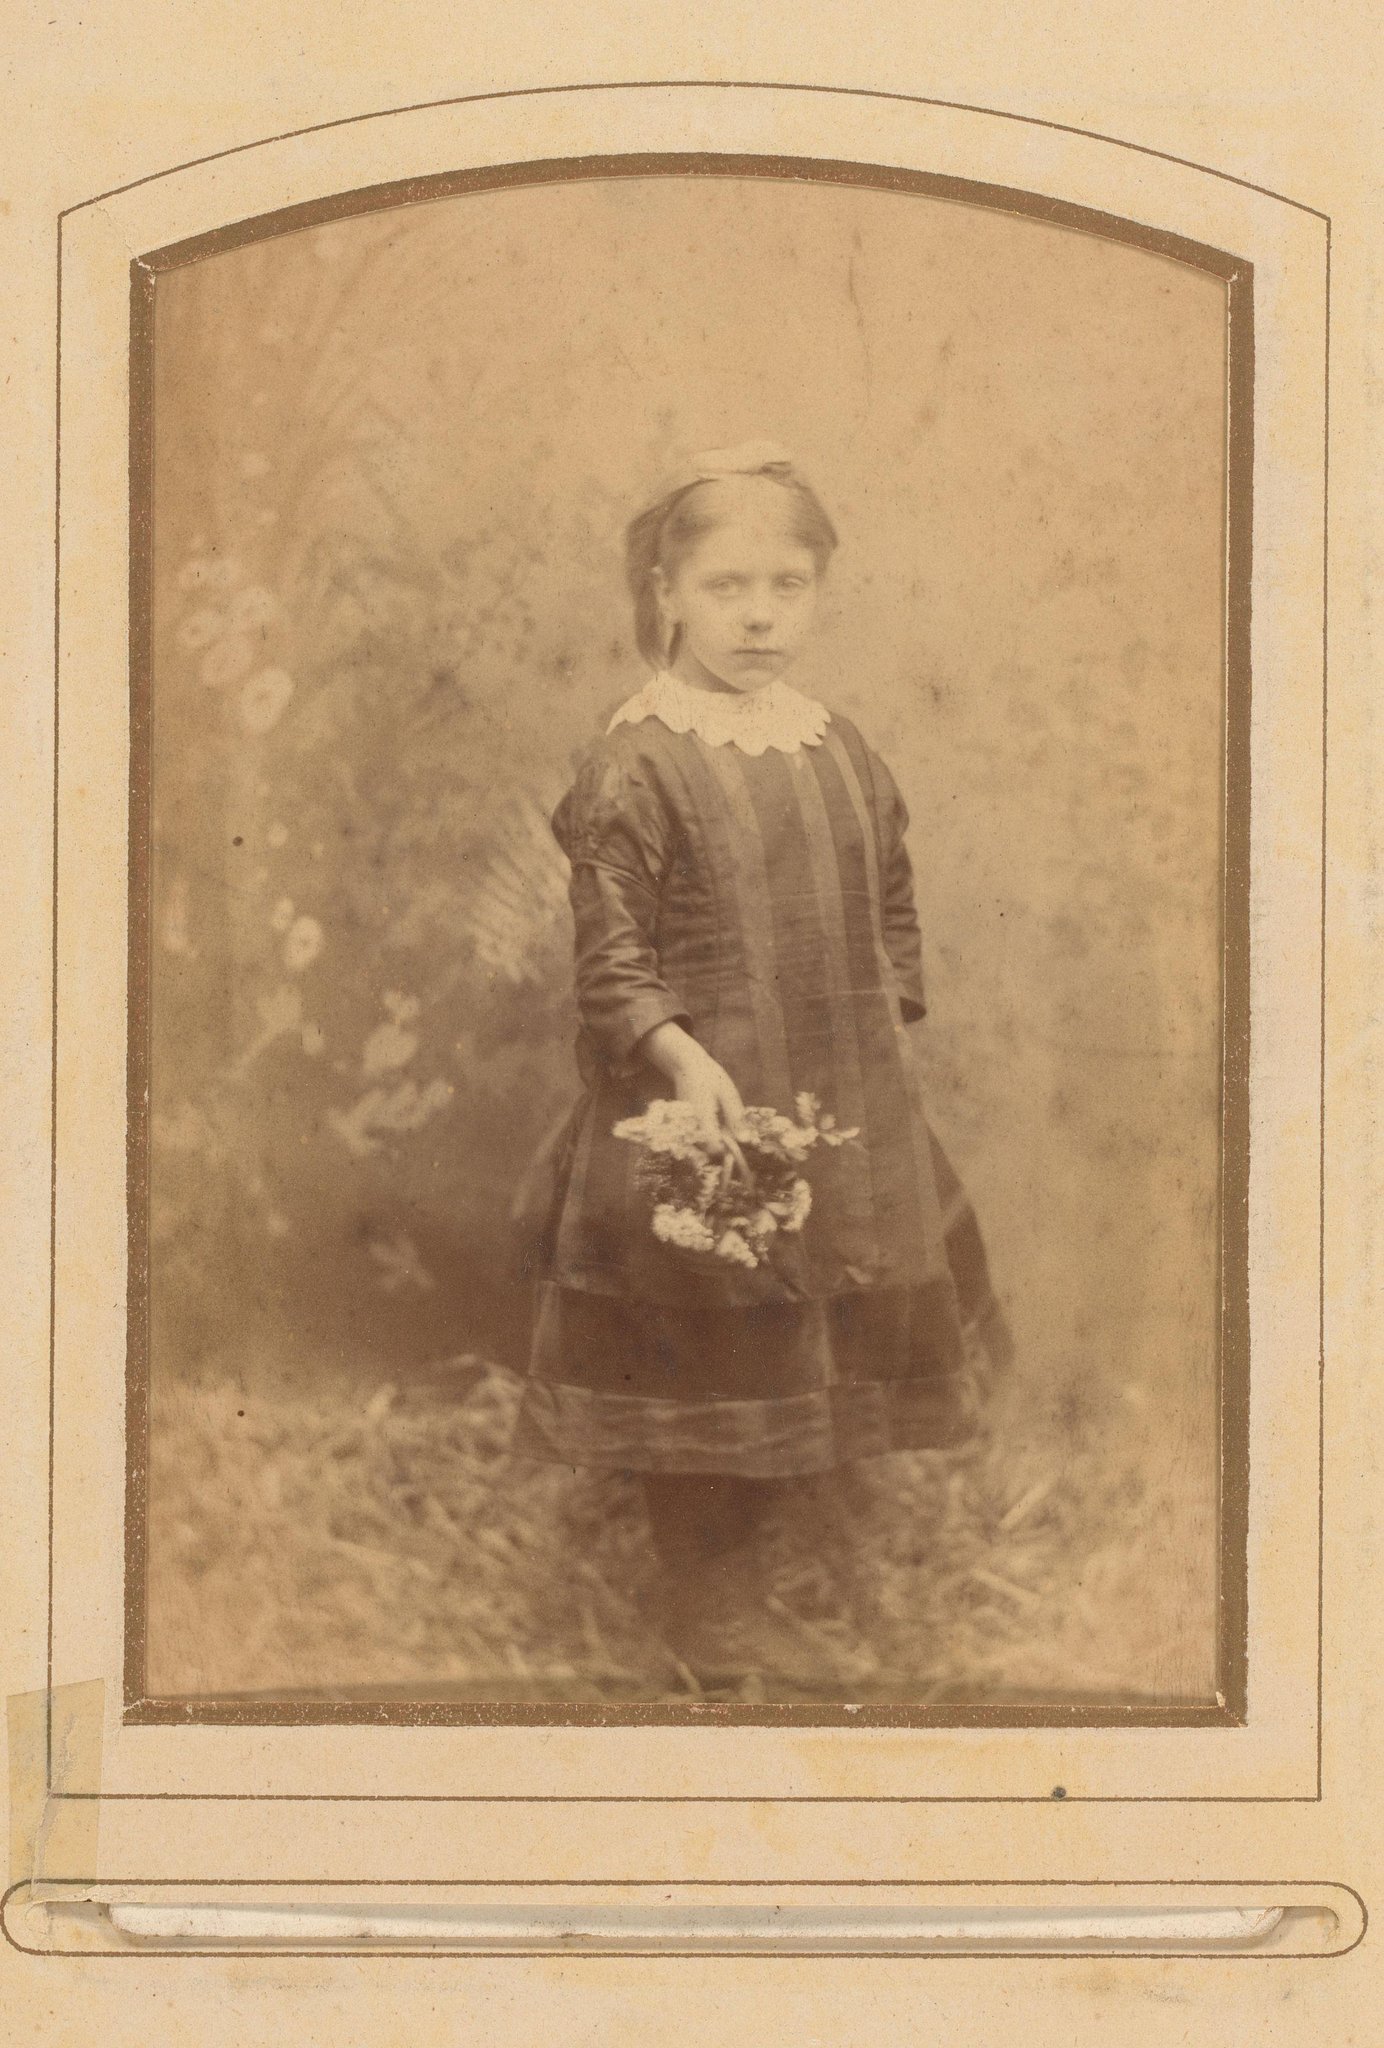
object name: album leaf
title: Portret van een staand meisje met bloemen in de hand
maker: Anonymous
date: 1860-1890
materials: cardboard, photographic support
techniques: albumen print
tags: flowers, historical persons - bb - woman, girl (child between toddler and youth)